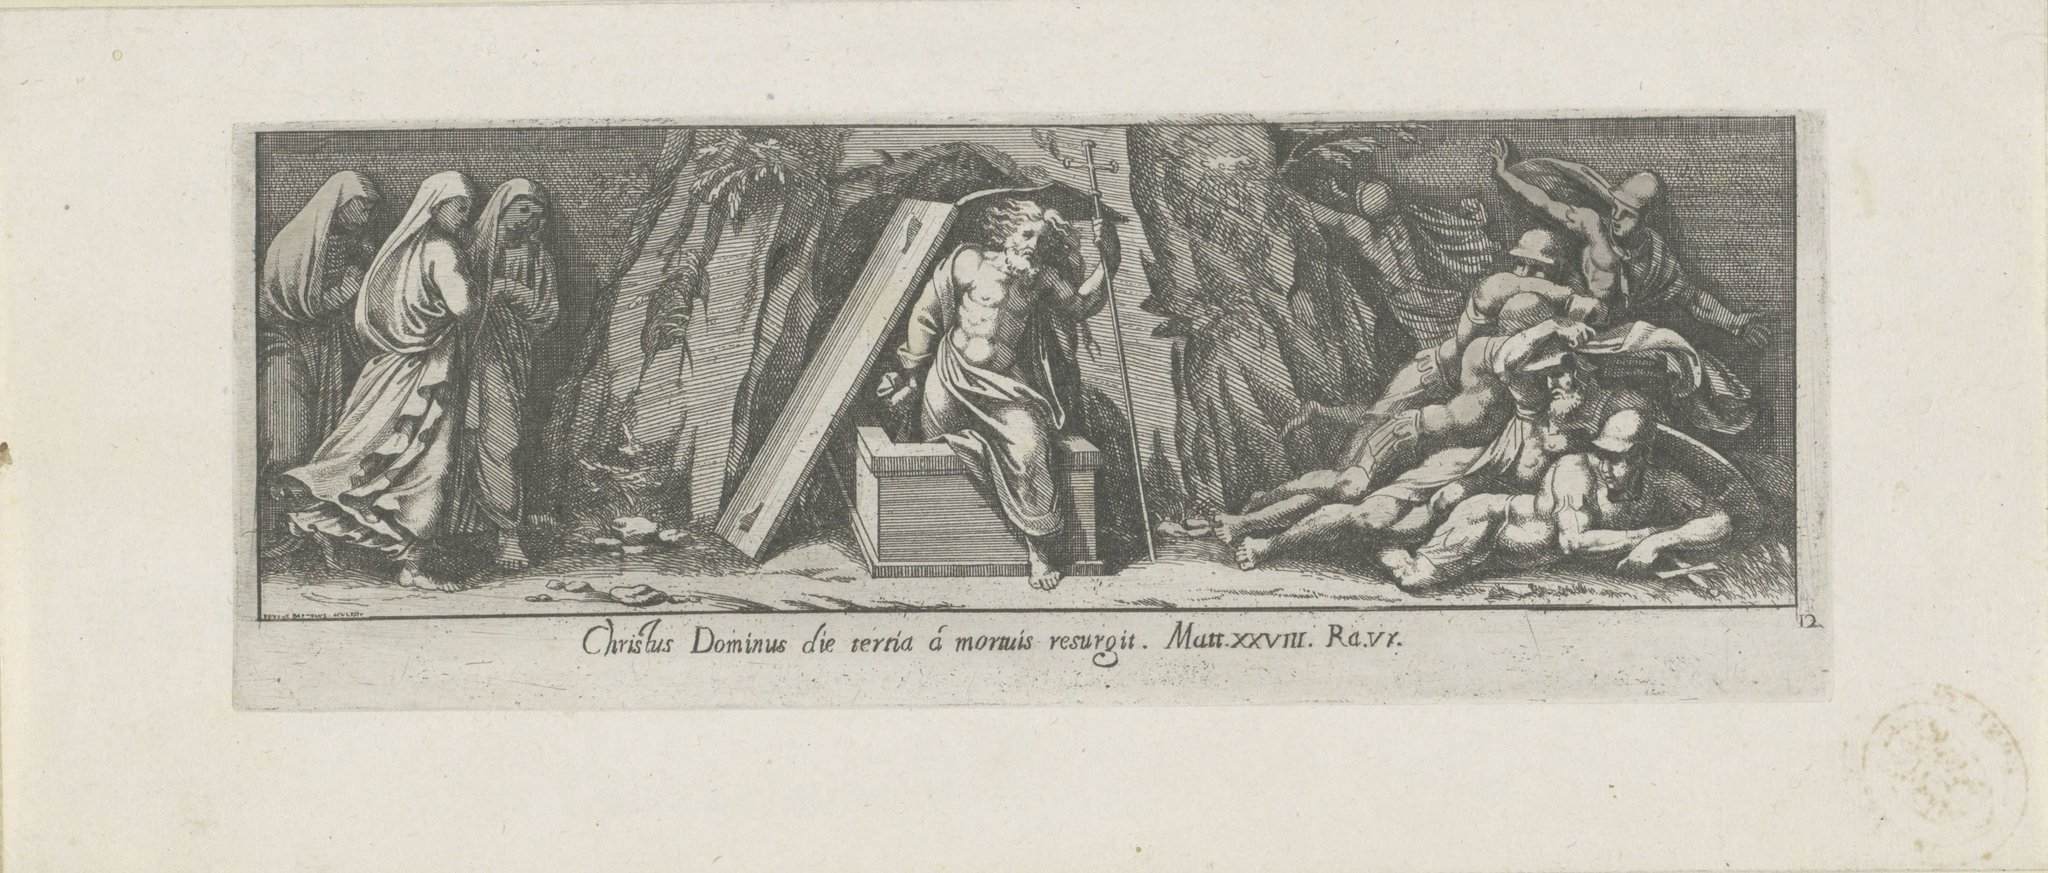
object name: print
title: Verloren gegane schilderderingen in de Vaticaanse Loggia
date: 1645-1700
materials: paper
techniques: engraving, etching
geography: vatican city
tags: christ, usually holding a banner, arises from the grave; often combined with sleeping and/or frightened soldiers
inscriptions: collector's mark: Lugt 240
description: Christus klimt uit een sarcofaag. Links de drie Maria's. Rechts een groep geschrokken soldaten. Titel en verwijzing naar Bijbeltekst in ondermarge.